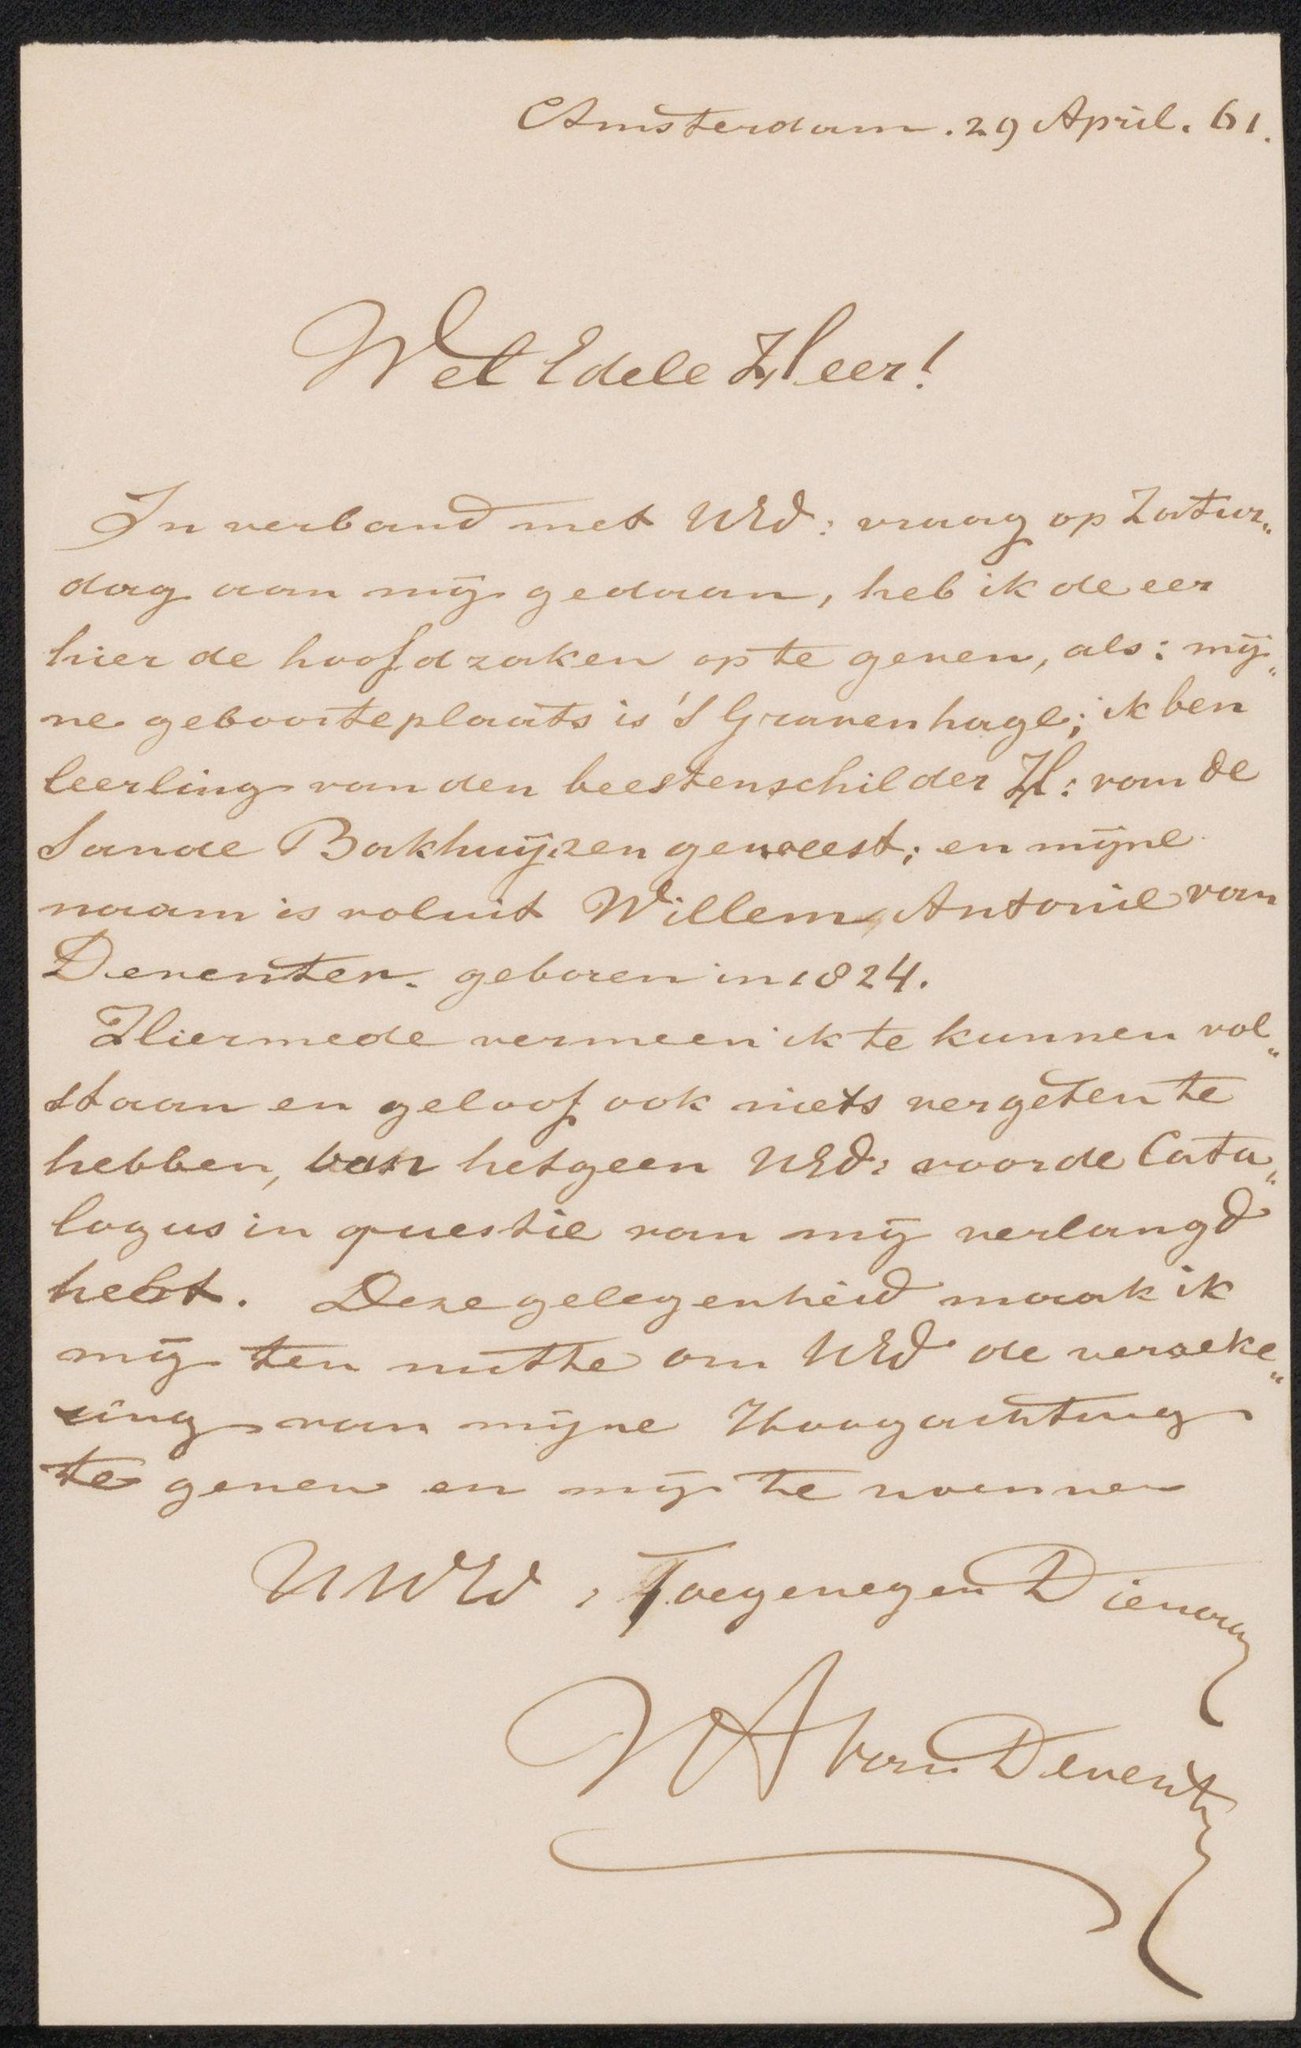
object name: letter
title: Brief aan Ary Johannes Lamme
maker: willem anthonie van deventer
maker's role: draughtsman, painter, print maker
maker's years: 1824-1893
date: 1861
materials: ink, paper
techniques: pen, writing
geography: amsterdam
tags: dordrecht, print maker, draughtsman, ary johannes lamme, the hague, painter, hendrikus van de sande bakhuyzen, education, tuition of the artist (in general), painting (including book-illumination, miniature-painting), printed matter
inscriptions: collector's mark: Lugt 2228